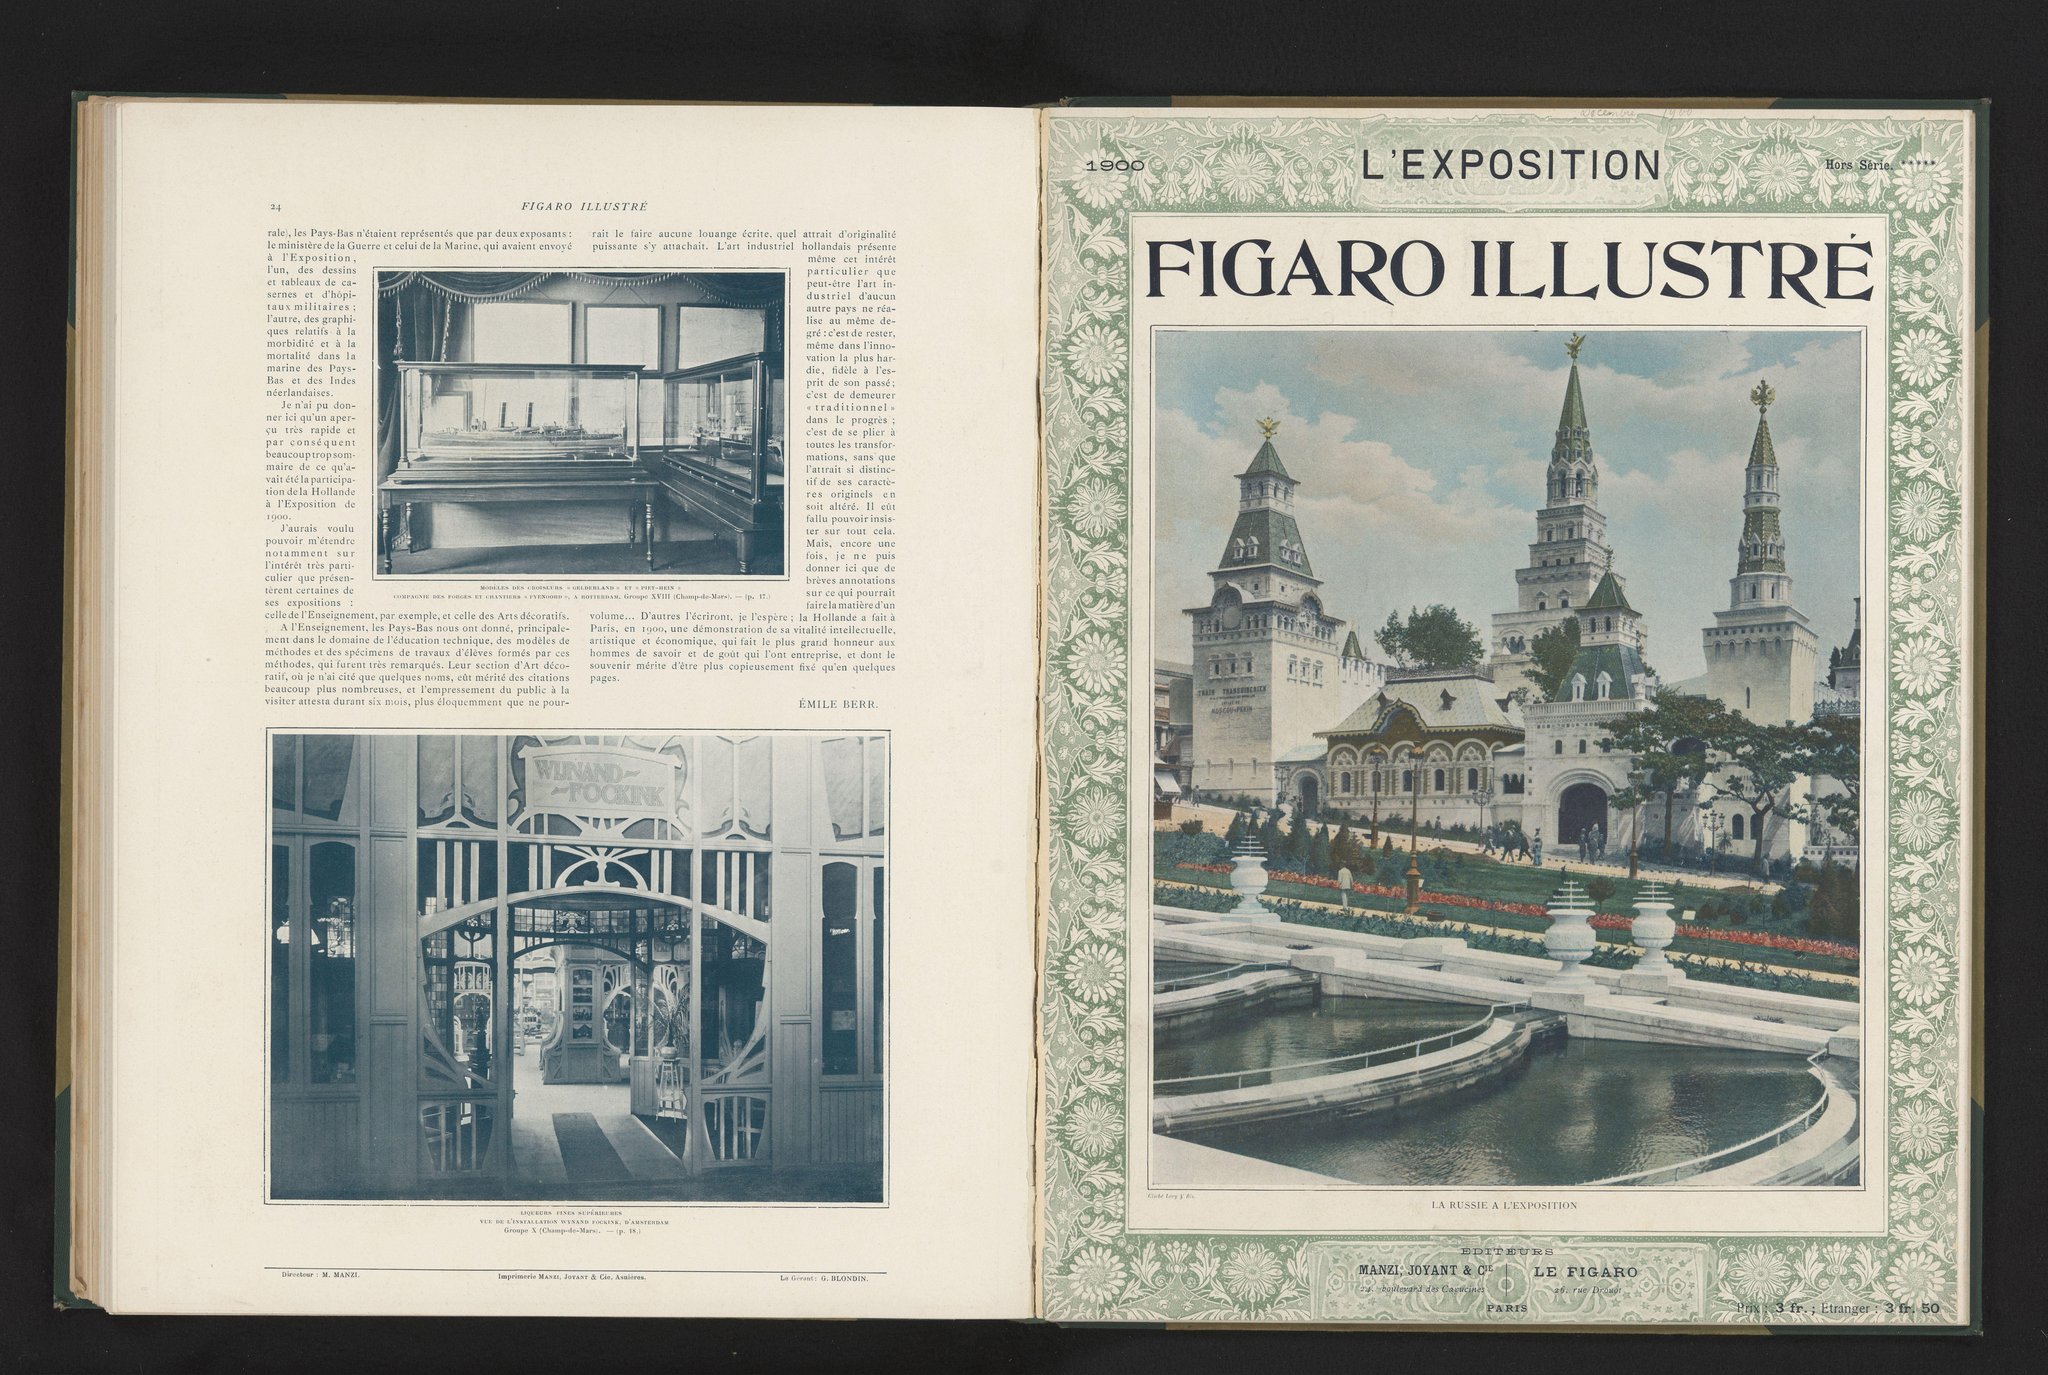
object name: page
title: La Russie a l'exposition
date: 1885-1901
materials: paper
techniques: four-color autotype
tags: world fair, world exhibition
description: Prent tegenover pagina 24 van Figaro-Illustré (December 1900).